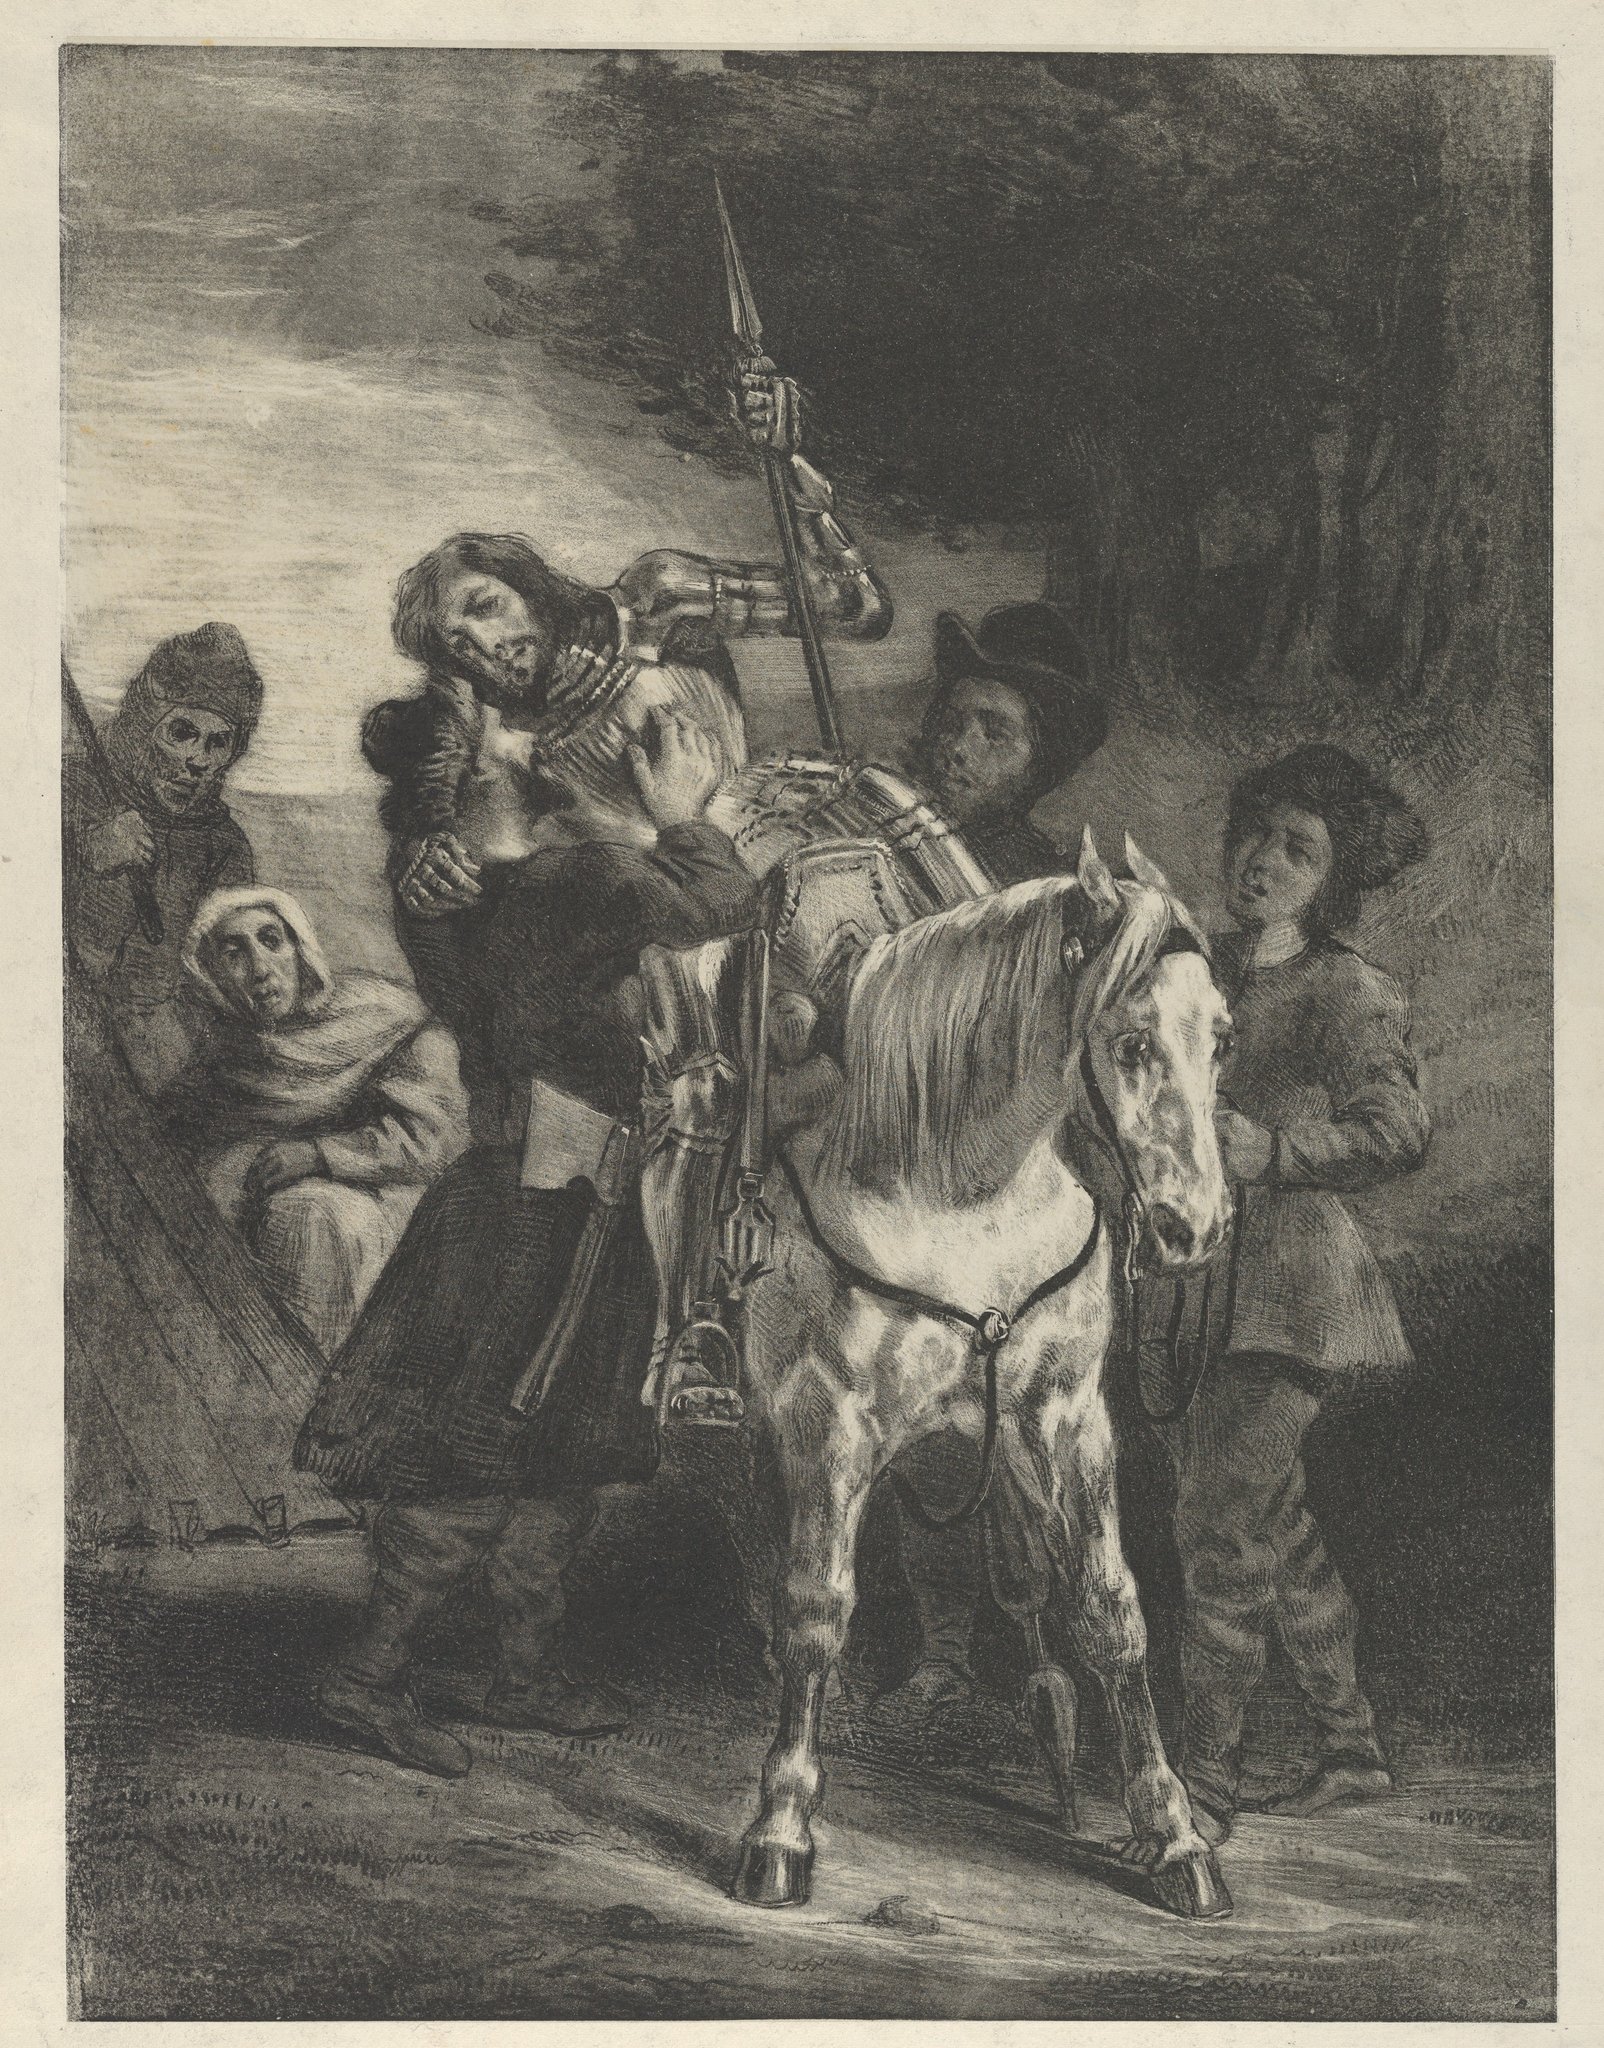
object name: print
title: The Wounded Goetz Taken in by the Gypsies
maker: eugène delacroix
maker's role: artist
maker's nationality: french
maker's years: 1798-1863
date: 1836-1843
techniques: lithograph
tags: spears,men,horses